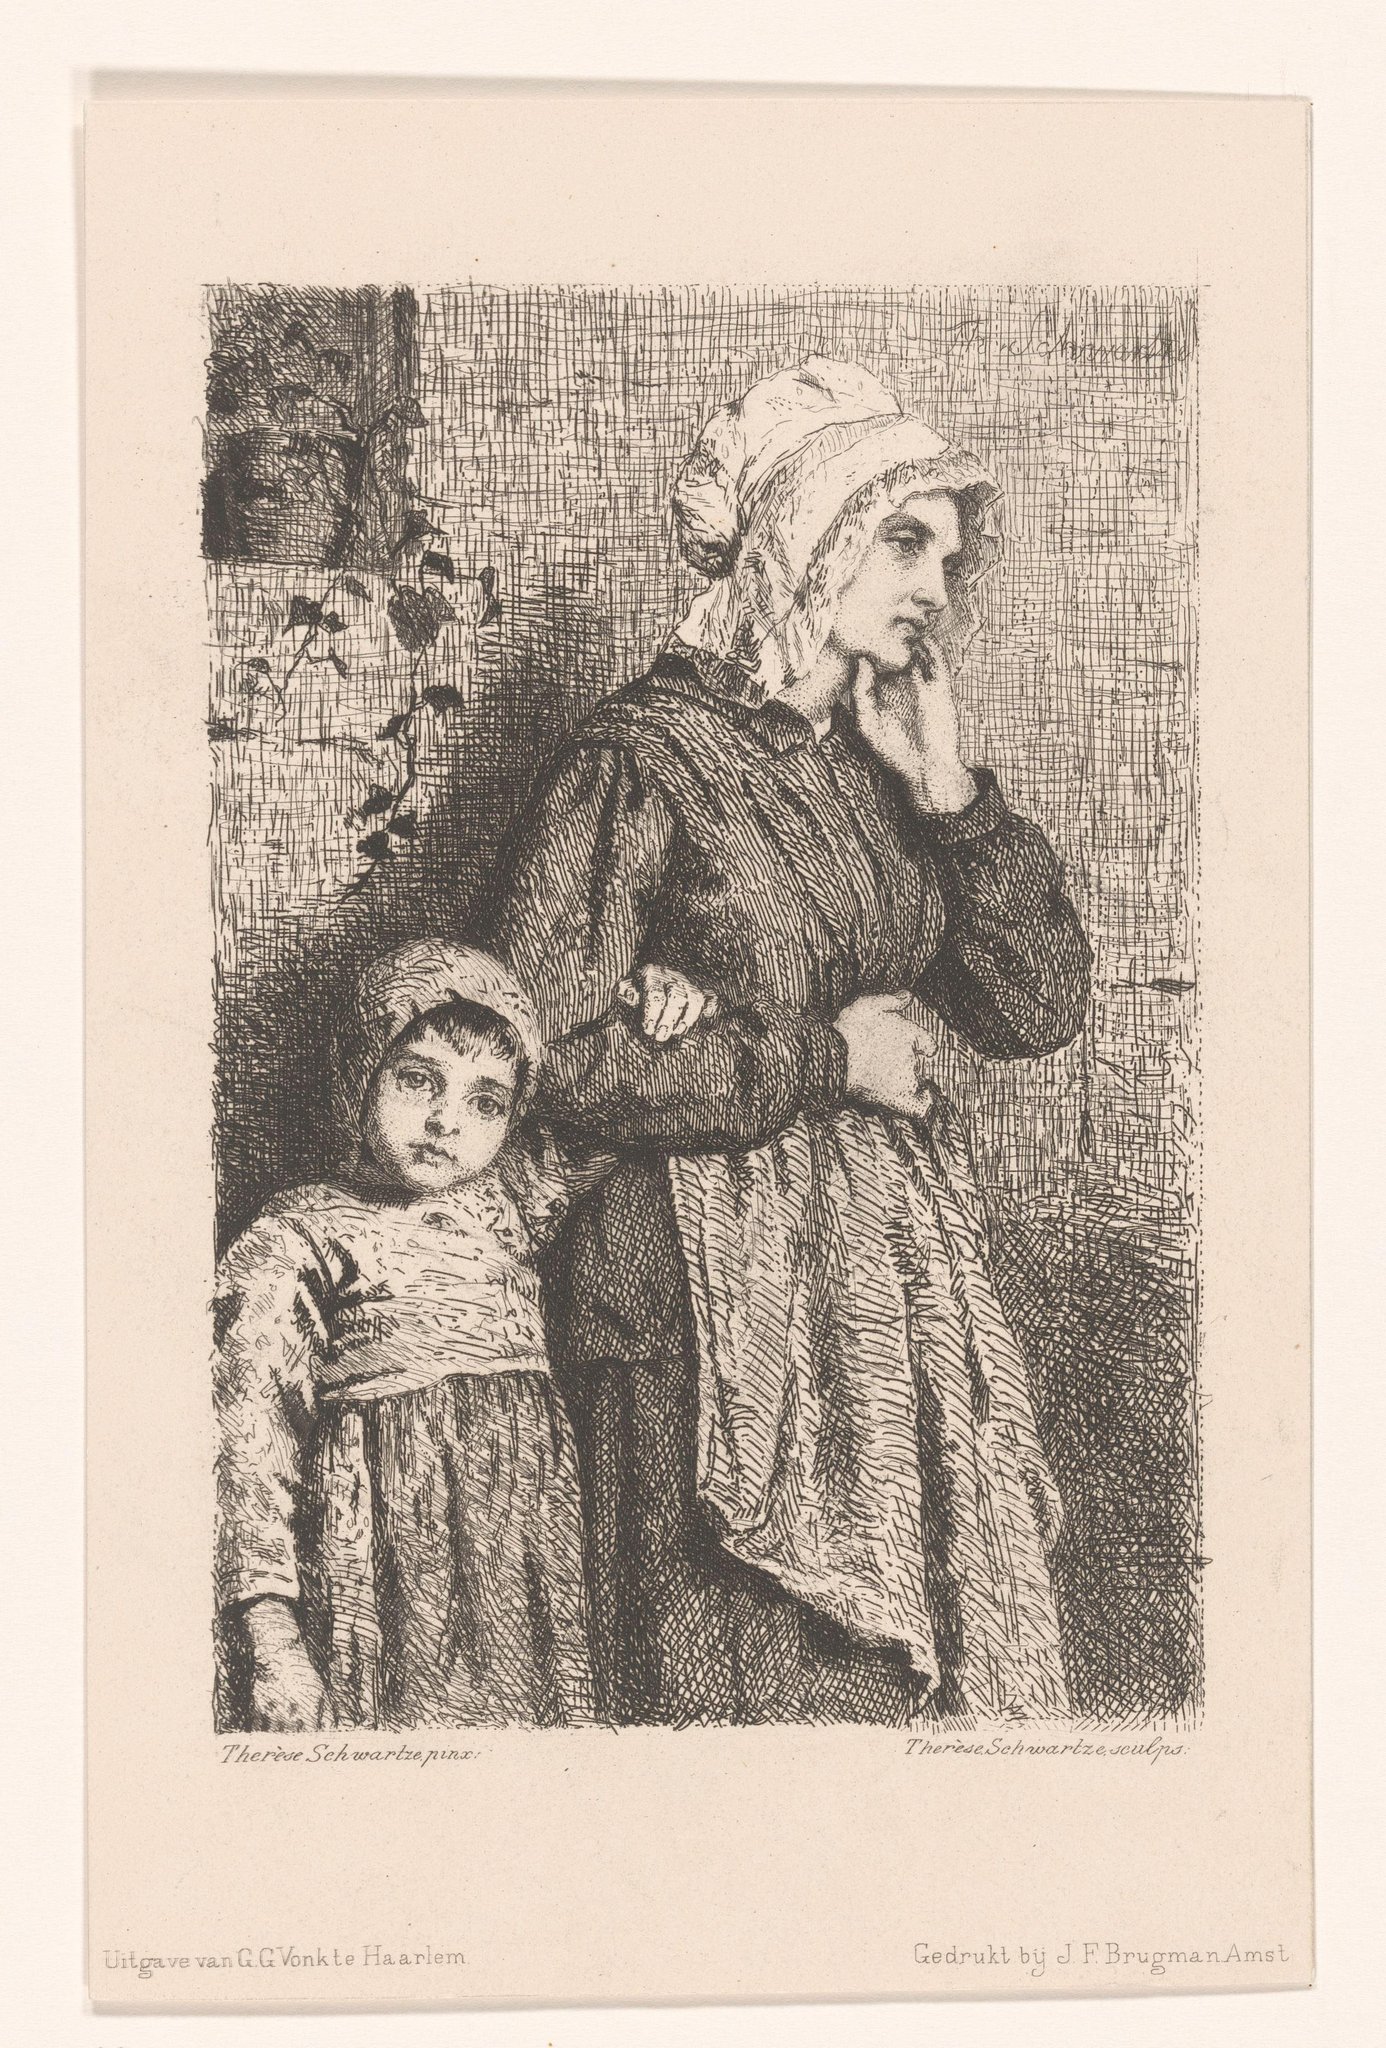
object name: print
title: Vrouw met kind aan de arm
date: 1861-1918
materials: paper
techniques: etching, letterpress printing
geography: amsterdam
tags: mother and child(ren), woman and child(ren) (family group)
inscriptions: collector's mark: Lugt 2228, collector's mark: Lugt 2760